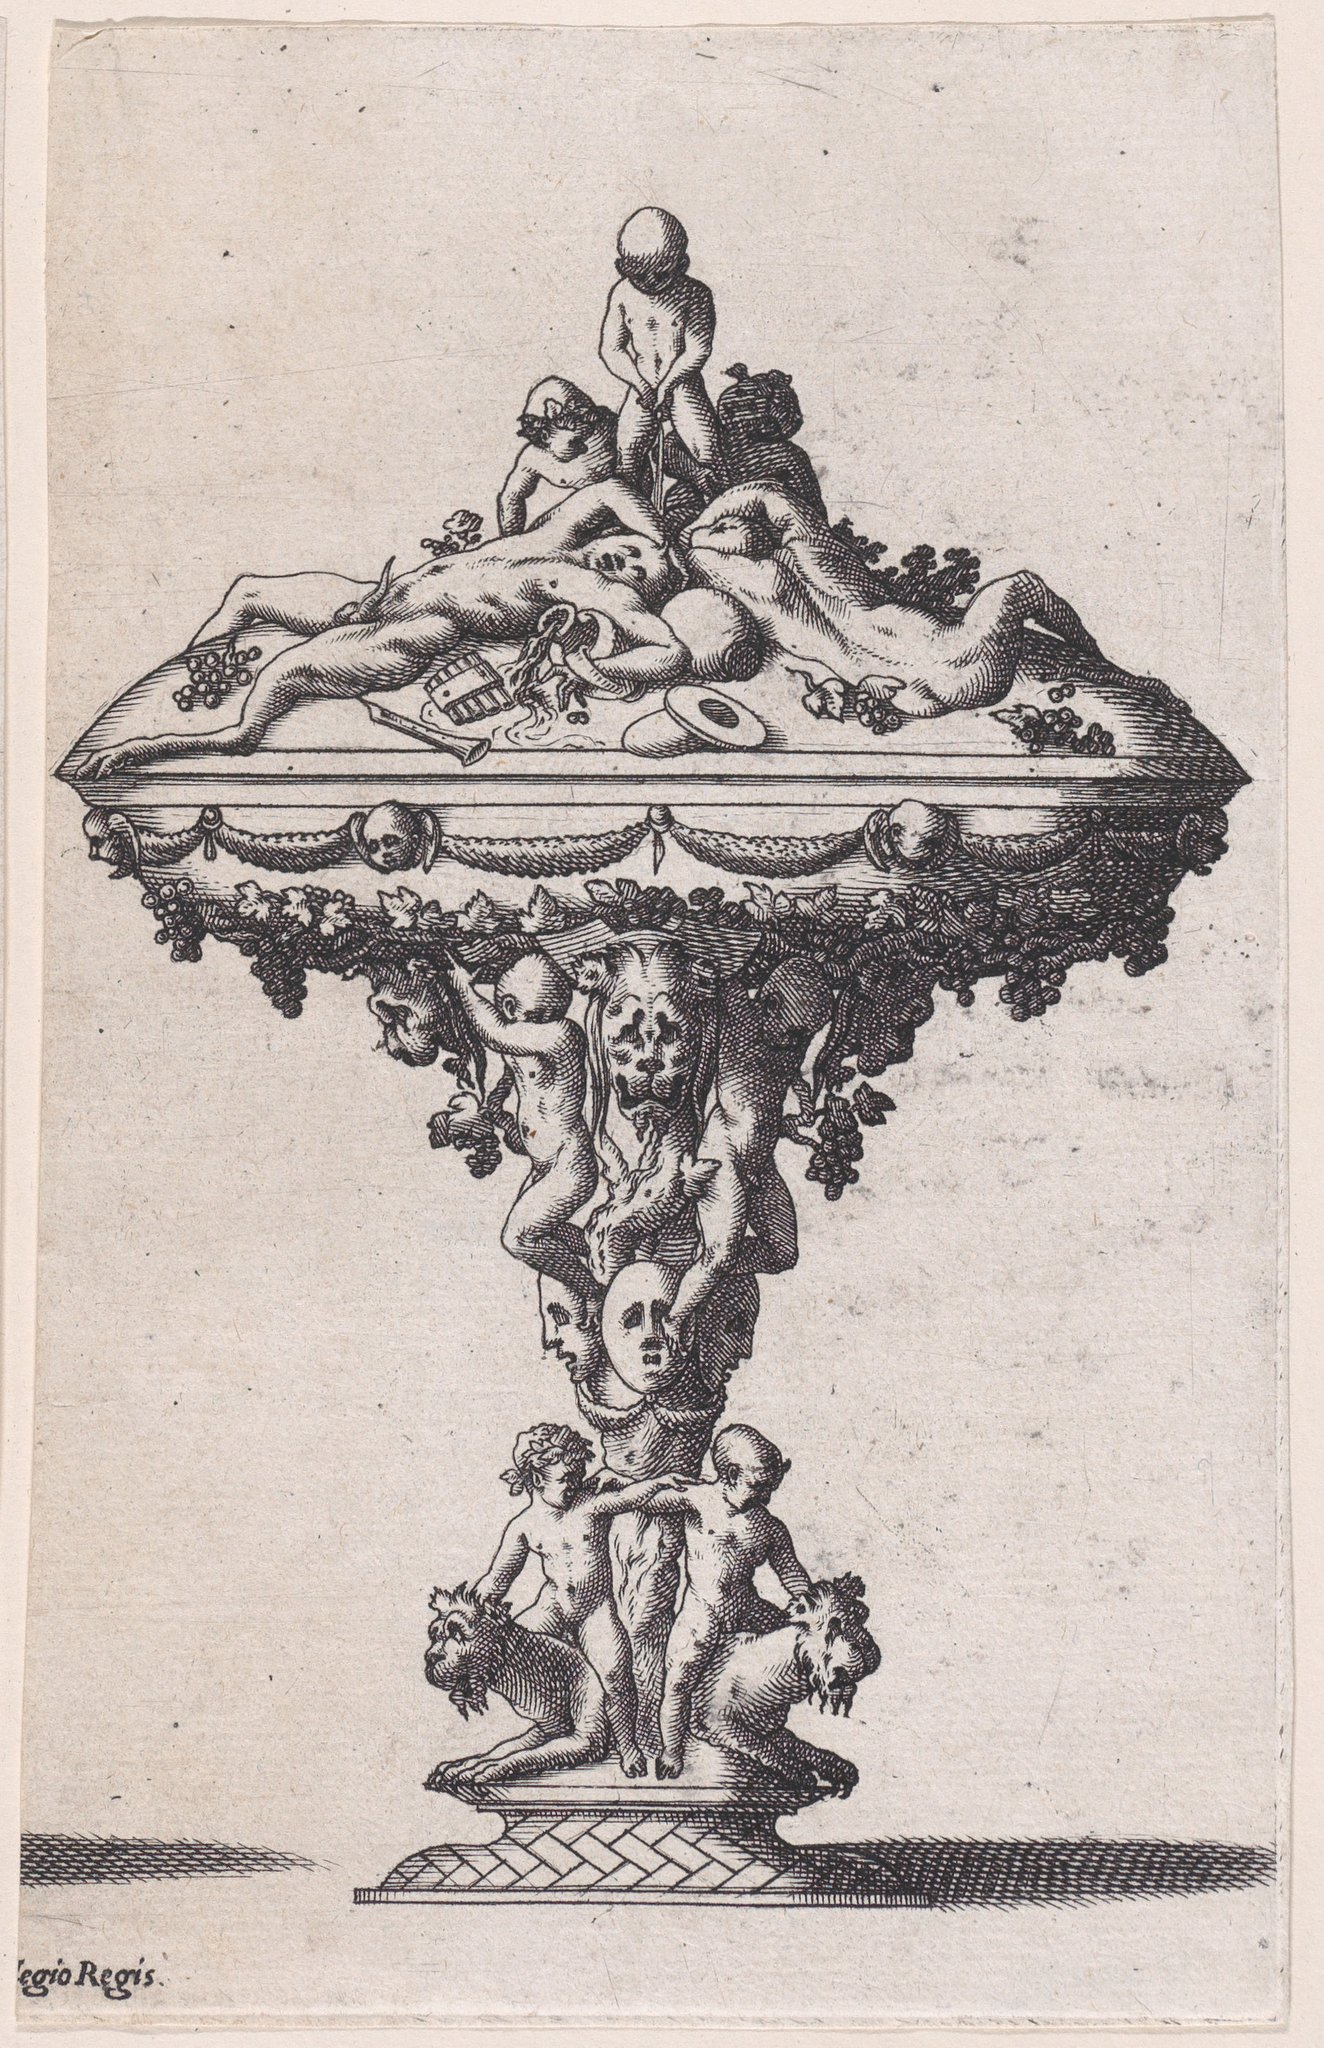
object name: print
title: Covered Cup with Children on the Base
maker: rené boyvin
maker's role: artist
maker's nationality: french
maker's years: 1525-1598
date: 1525-1600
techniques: engraving